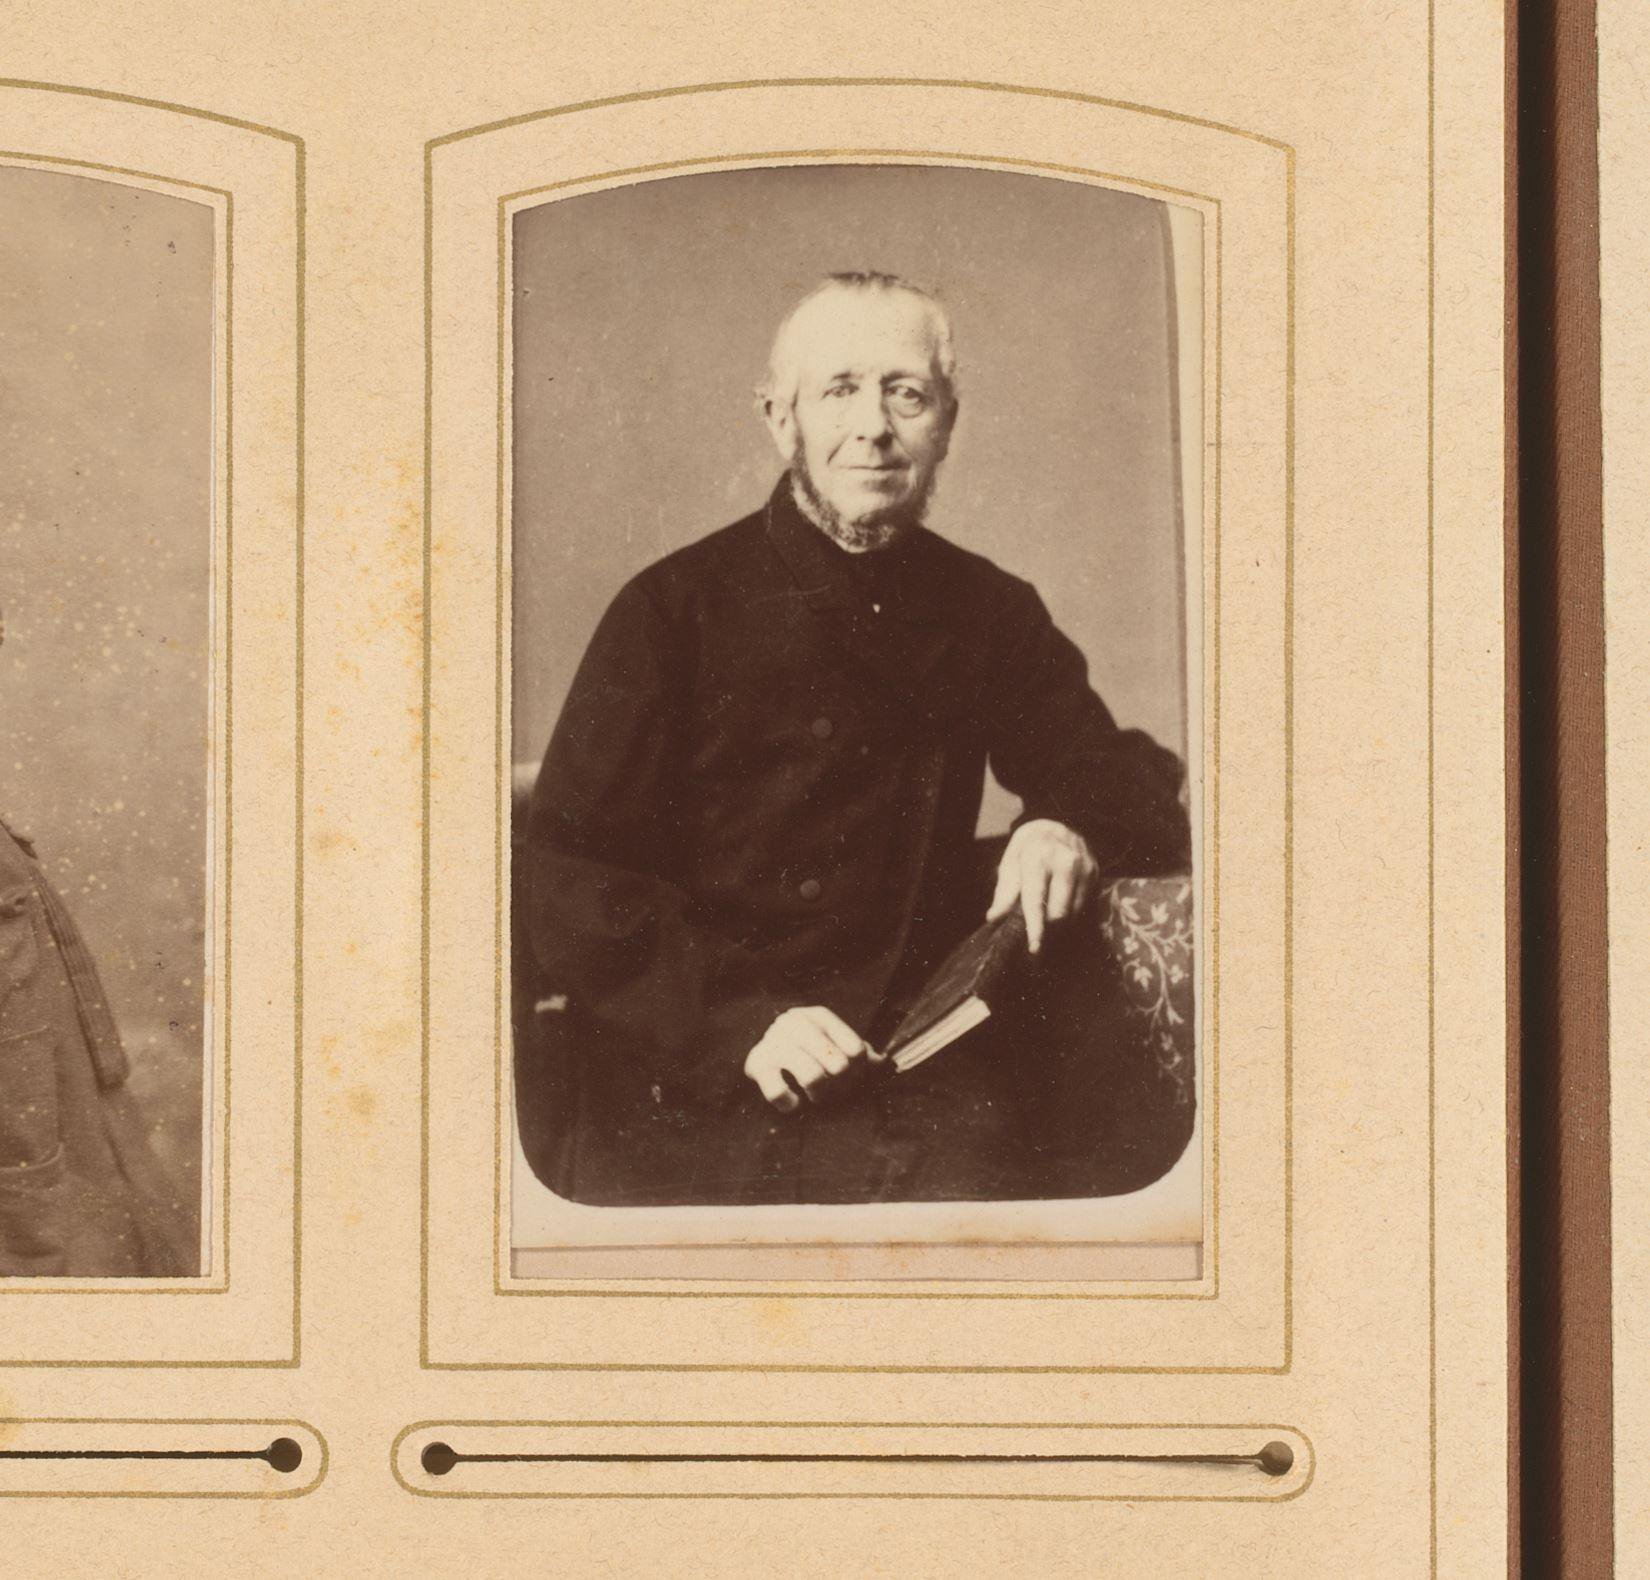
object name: photograph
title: Portret van een zittende man met boek in de hand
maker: willem gerhardus kuijer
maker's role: fotograaf, hoffotograaf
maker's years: 1834-1899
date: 1862-1899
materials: cardboard, photographic support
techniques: albumen print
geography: amsterdam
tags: sitting figure, historical persons, book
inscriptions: inscription: ‘Amsterdam/ W.G. Kuijer/ Westermarkt 19’